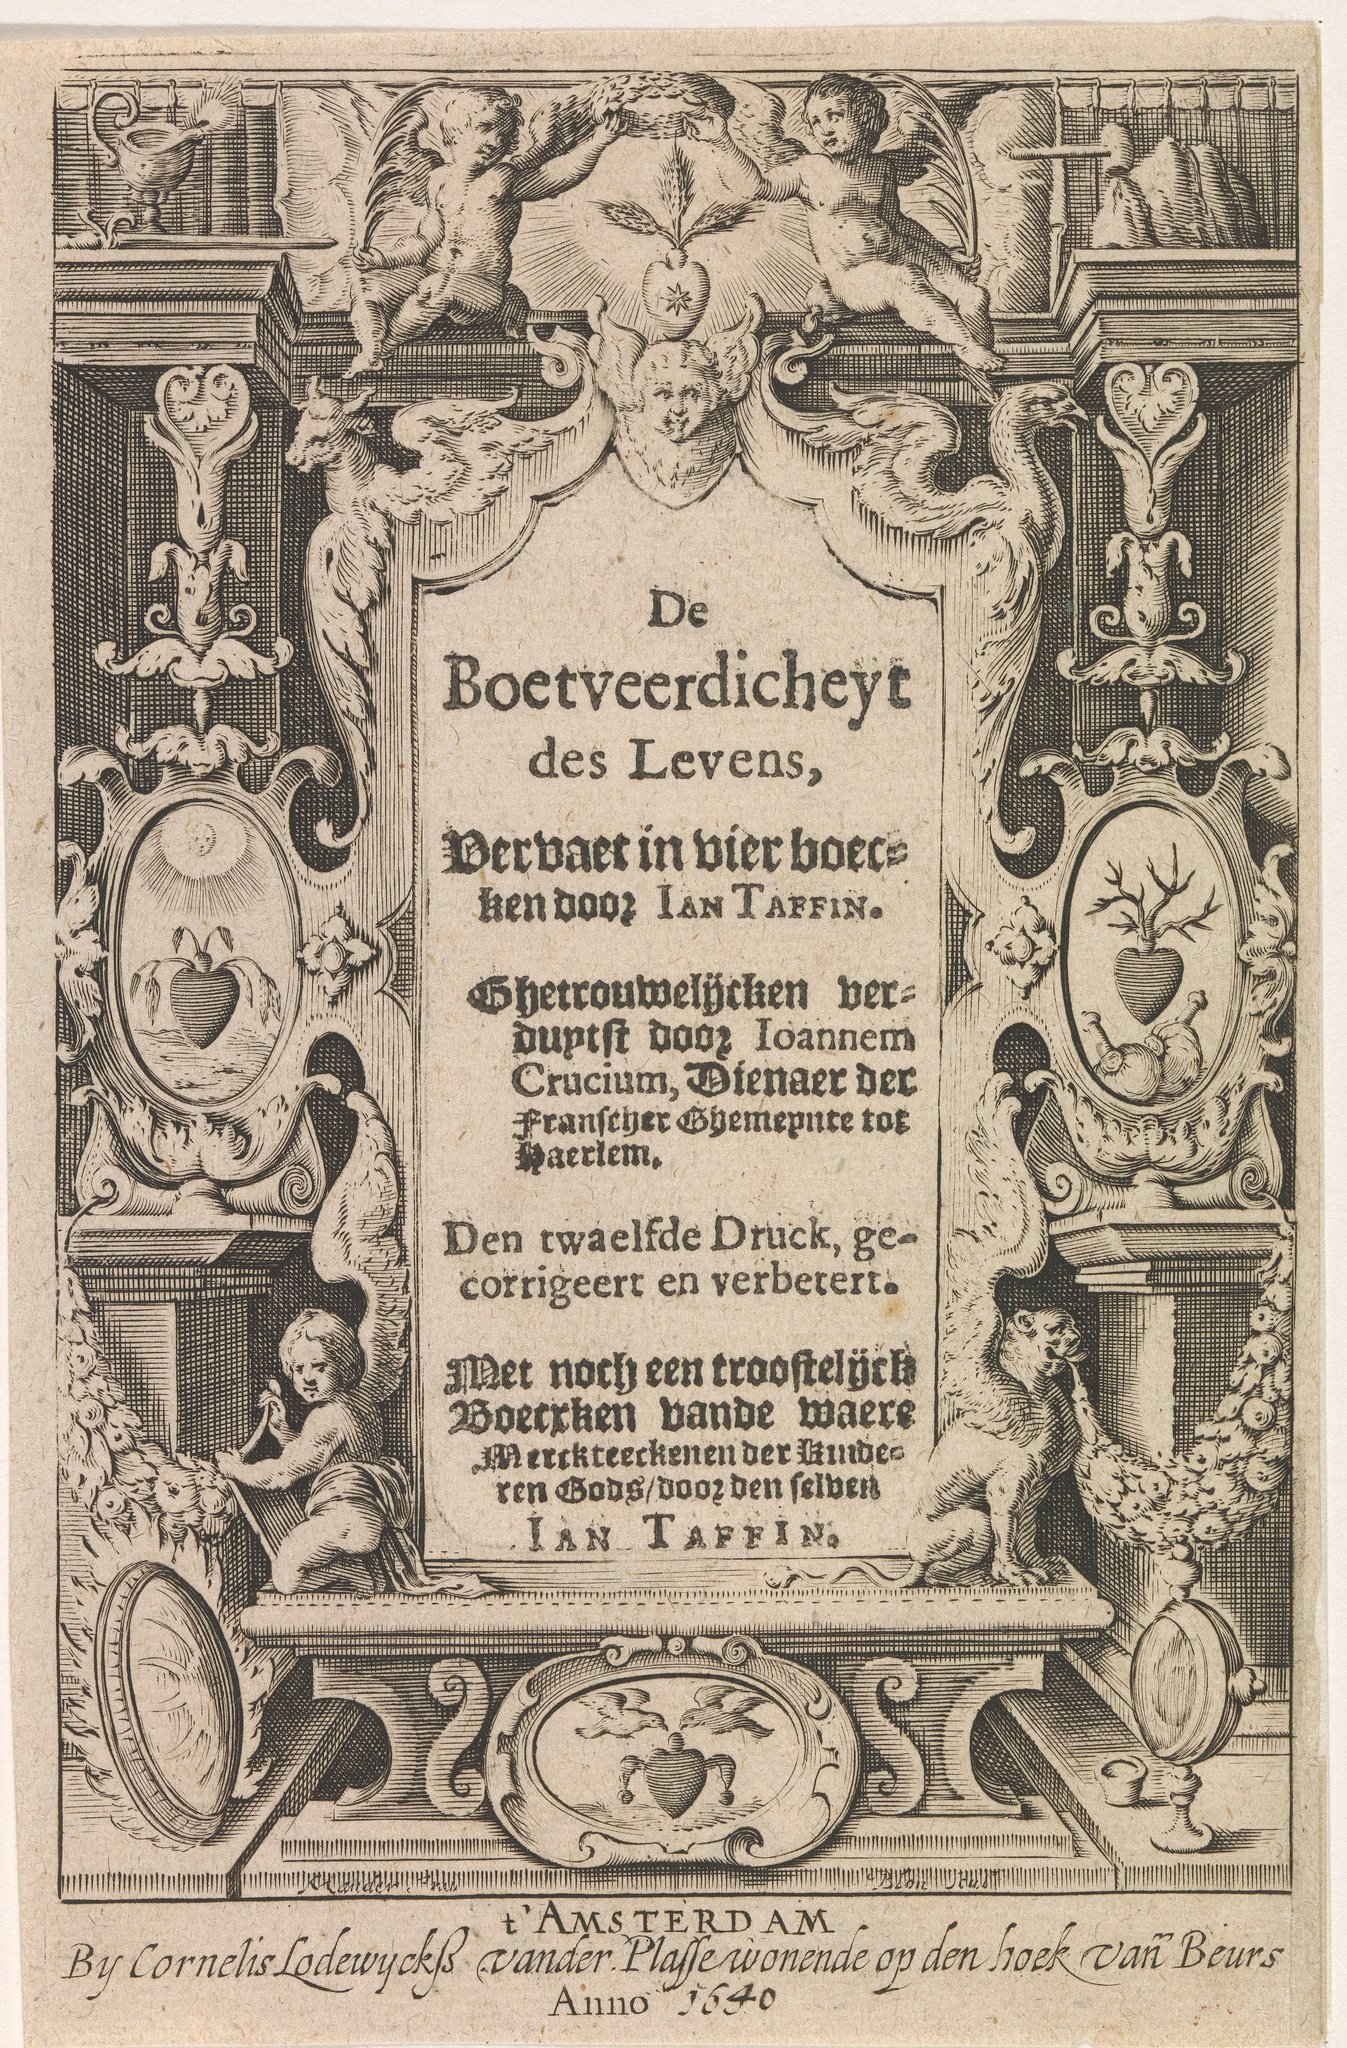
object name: titelblad, titelpagina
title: Twee putti kronen een vruchtbaar hart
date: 1640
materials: paper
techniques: engraving, etching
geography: amsterdam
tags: heart symbolism, the sacred heart, the four symbols of the evangelists, 'the apocalyptic beasts'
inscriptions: collector's mark: Lugt 2228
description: Boven het vellum met de titel van het boek kronen twee putti een met korenaren gevuld vruchtbaar hart. Rechts en links naast het vellum cartouches met een dor en verdord hart gevuld met verdroogde korenaren. Onderaan pikken twee vogels van een hart in de vorm van een narrenkap. De hoeken van het vellum zijn versierd met de symbolen van de vier evangelisten.